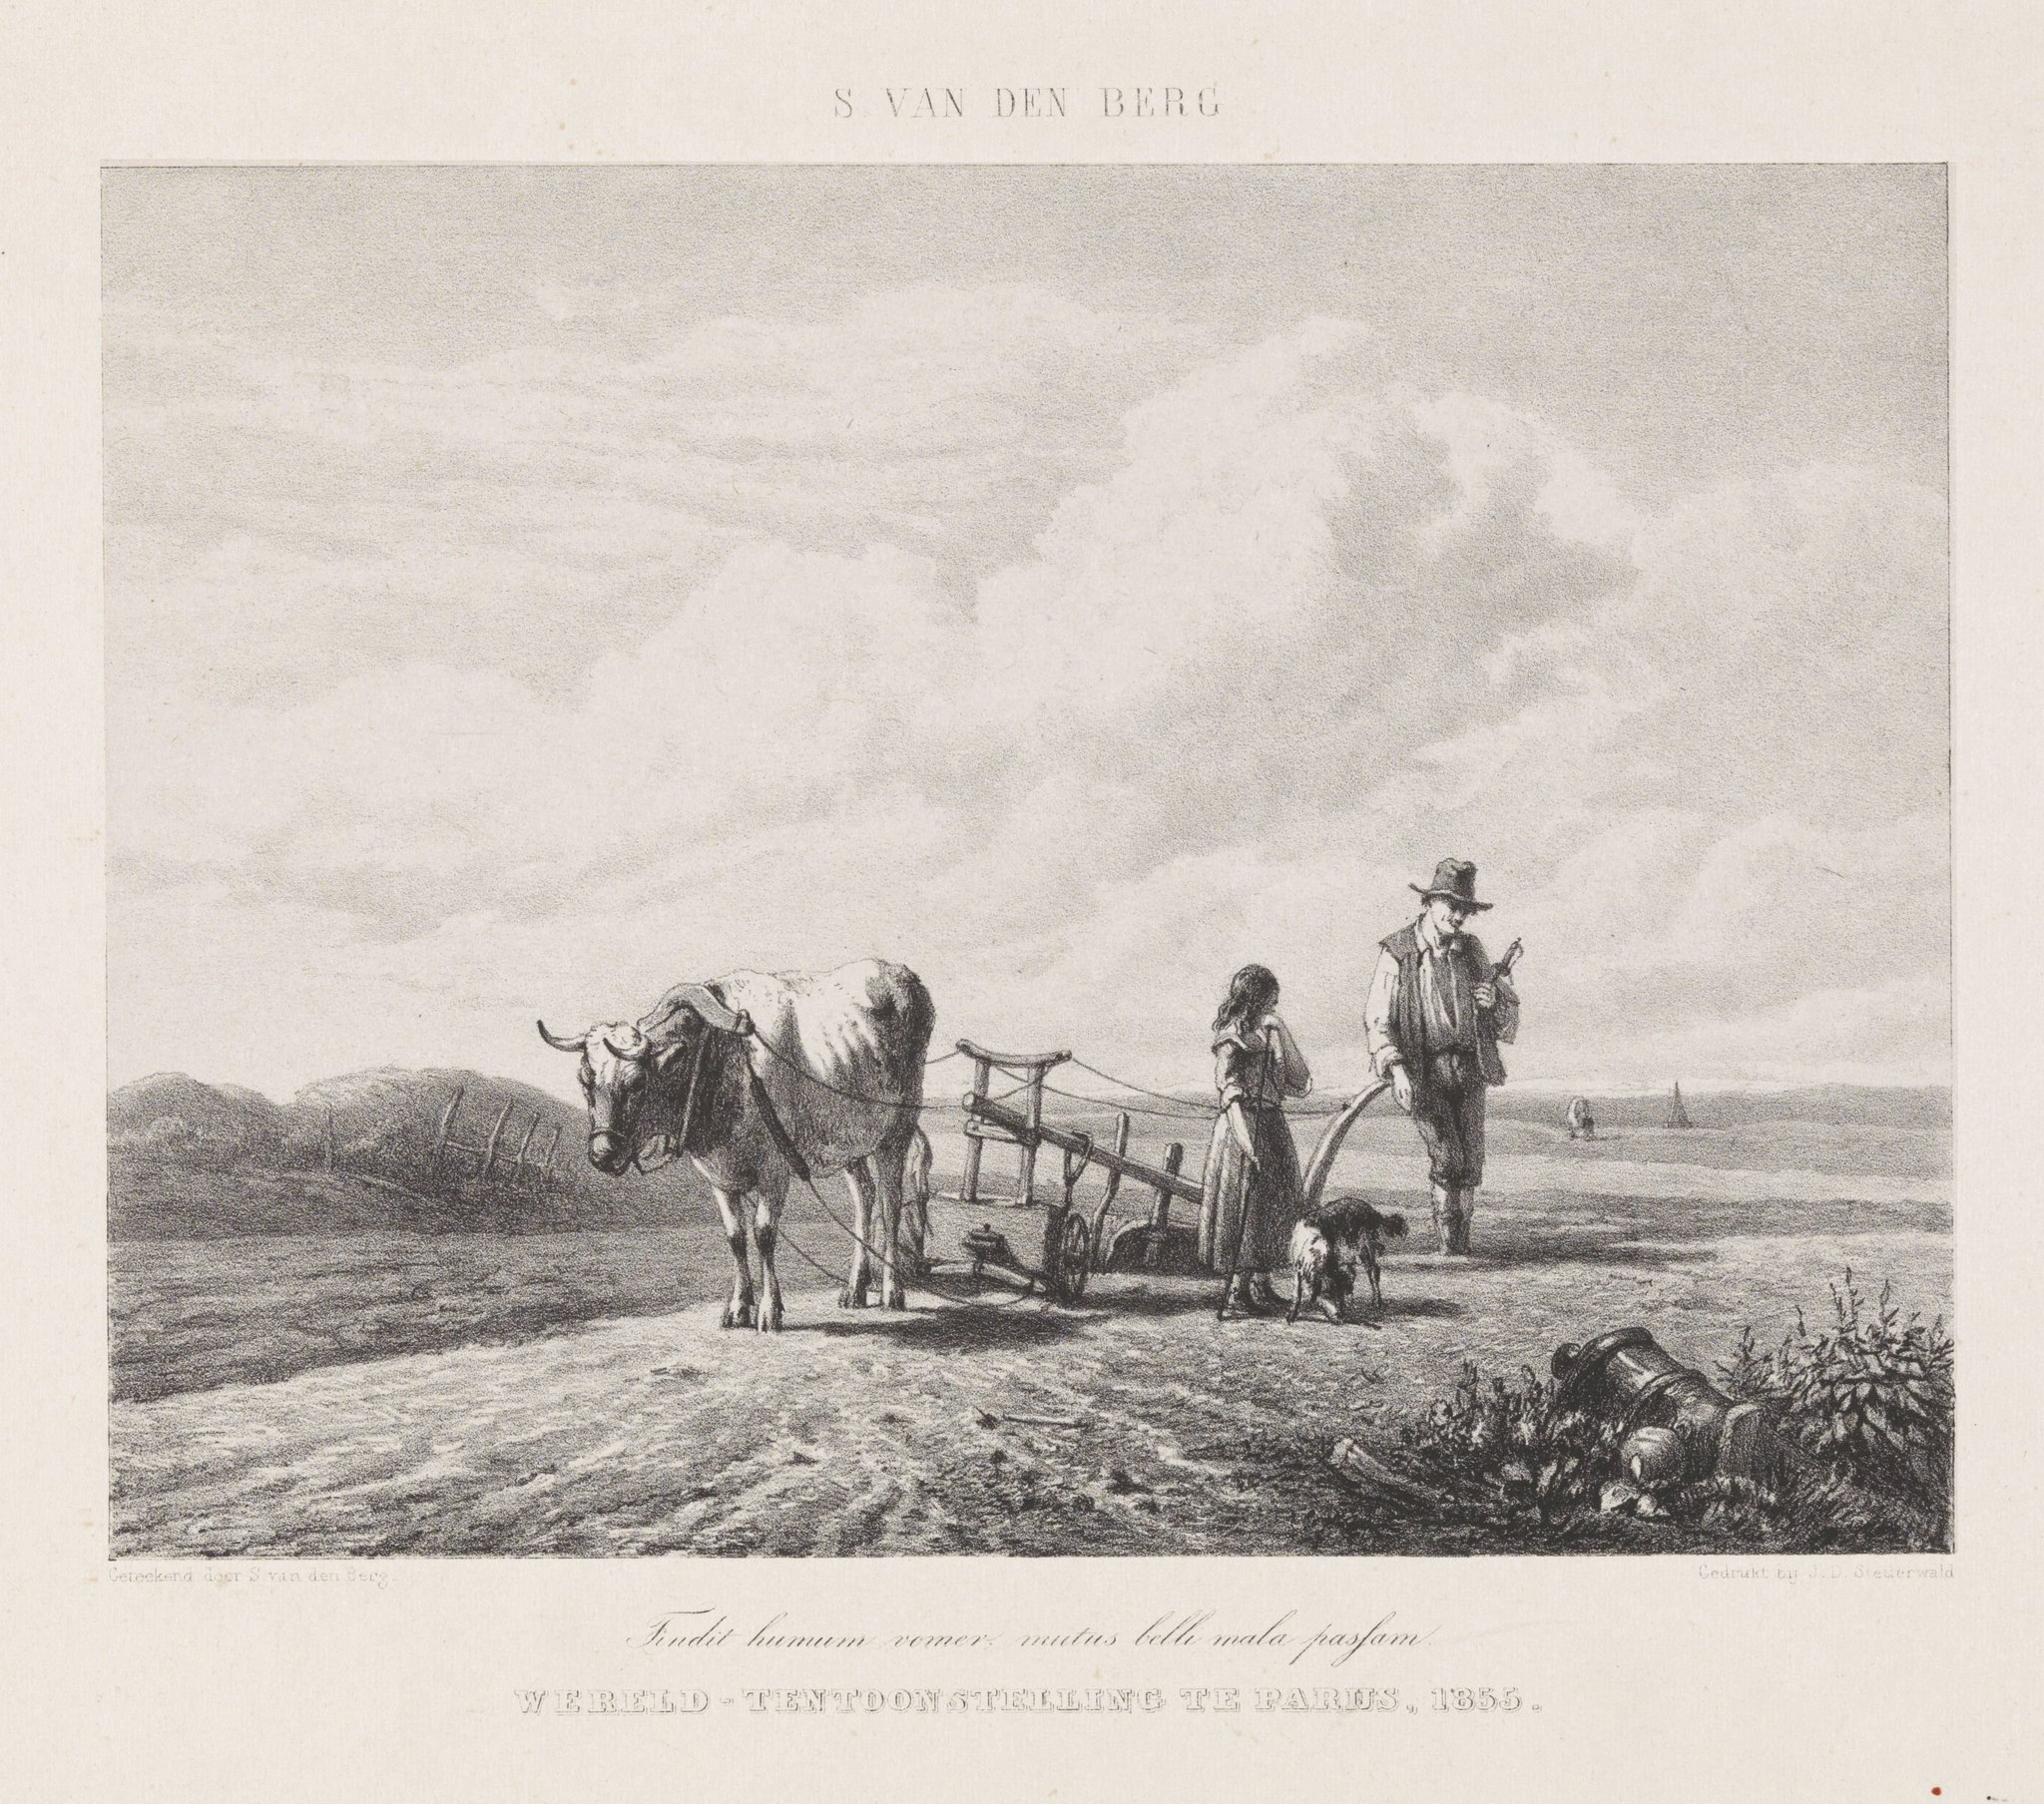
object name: print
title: Boeren vinden wapens op het land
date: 1855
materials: paper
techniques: lithograph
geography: netherlands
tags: war (+ weapons), agricultural implements: plough, conversation, dialogue; conversation piece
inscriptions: collector's mark: Lugt 2228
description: De man en vrouw staan stil bij een ploeg. De vrouw leunt op een lange stok. Voor de ploeg staat een rund. De man kijkt naar een dolk in zijn hand. In de voorgrond ligt een kanon. Onder de afbeelding staat een onderschrift in Latijn: "Findit humum vomer mutus belli mala passam".